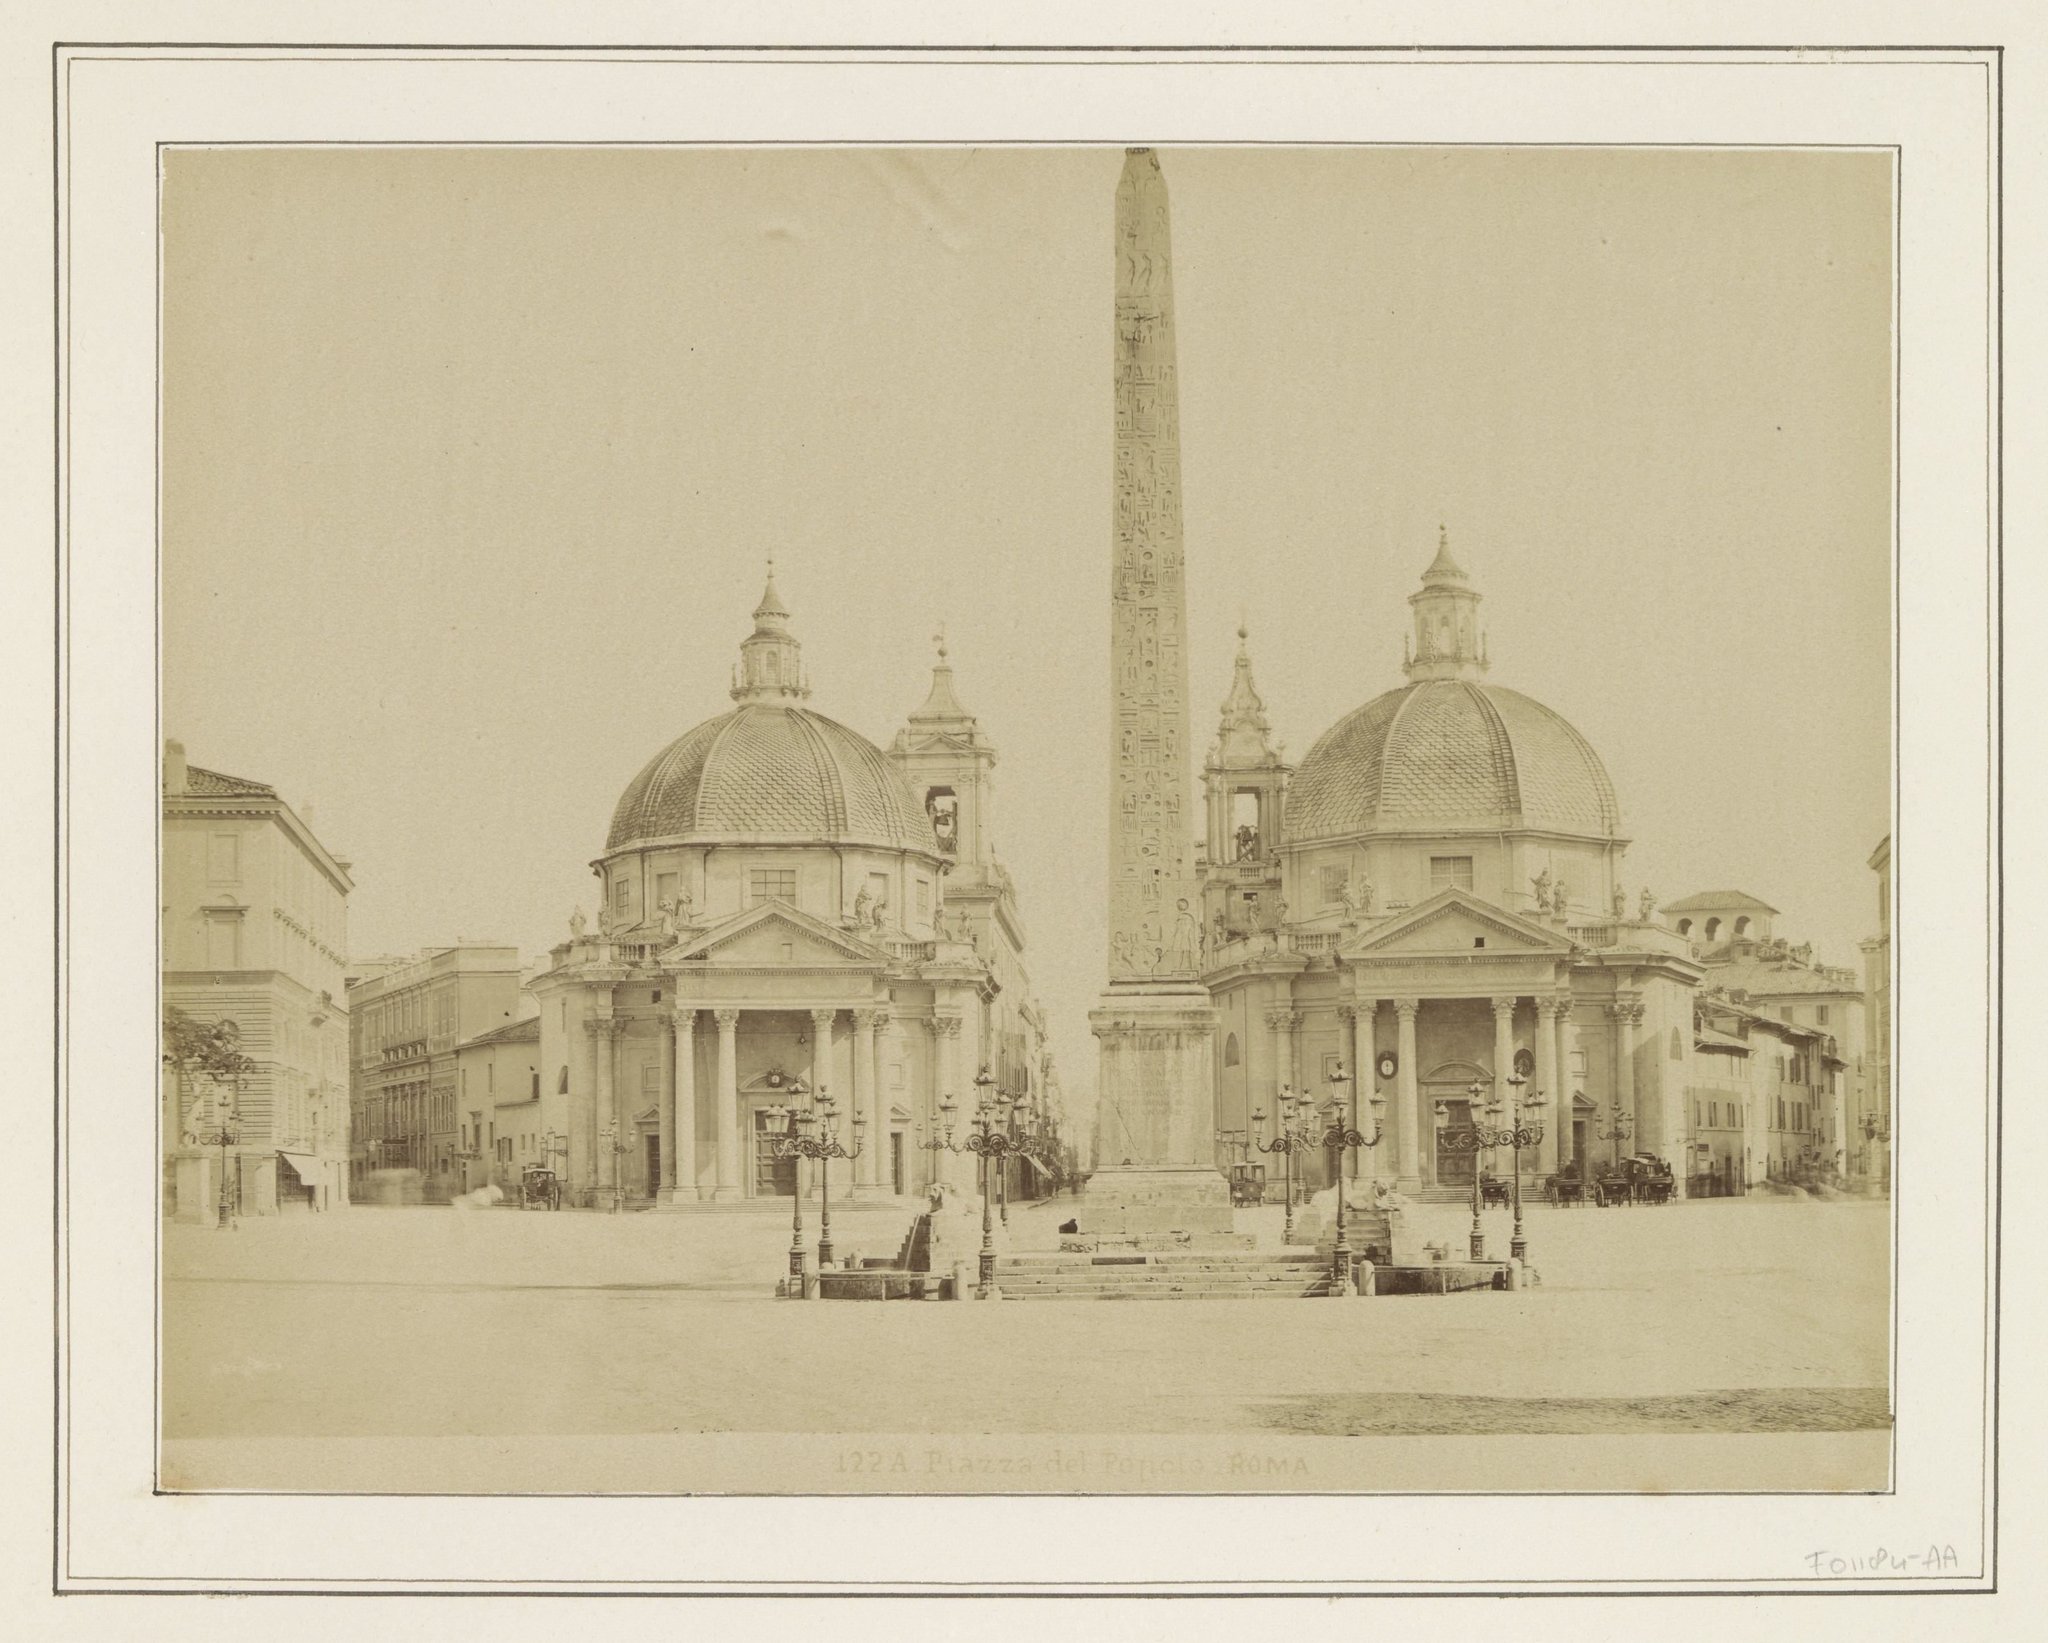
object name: photograph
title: Piazza del Popolo in Rome met de Santa Maria di Montesanto (links), de Santa Maria dei Miracoli (rechts) en een Egyptische obelisk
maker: Anonymous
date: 1865-1890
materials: paper, photographic support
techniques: albumen print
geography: piazza del popolo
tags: church (exterior), monument, statue, square, place, circus, etc. (+ city(-scape) with figures, staffage), rome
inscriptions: negative number: ‘122A’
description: Onderdeel van Reisalbum met foto's van bezienswaardigheden in Italië (deel I).